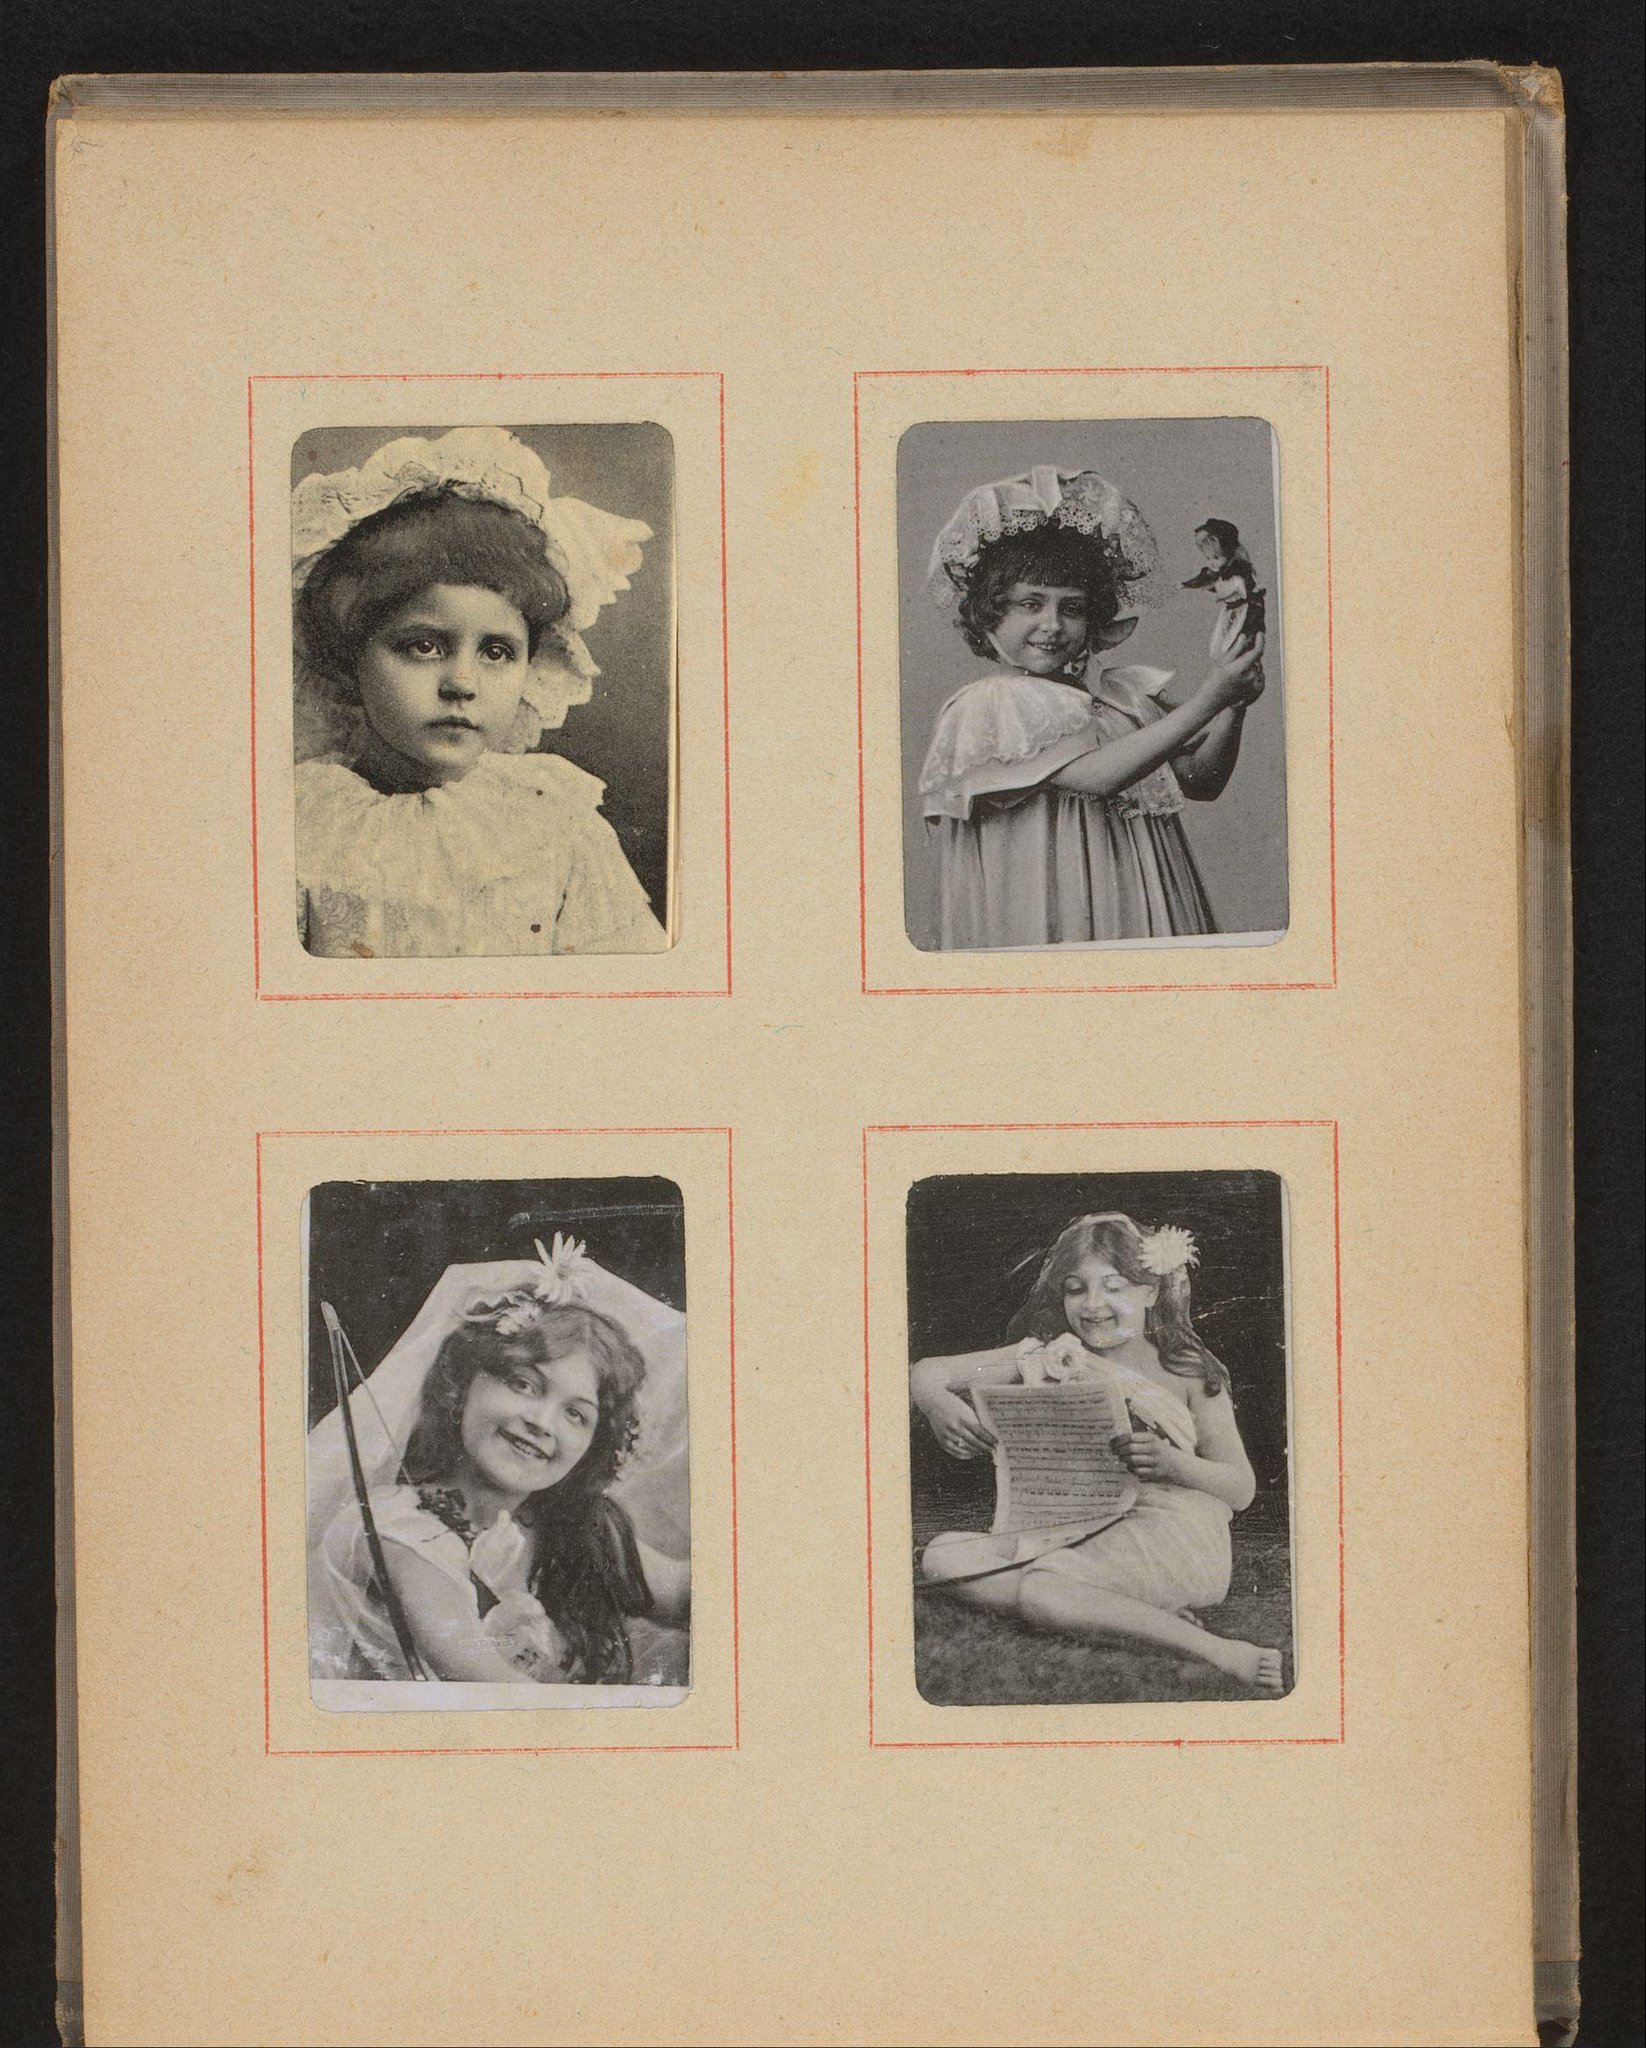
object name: photomechanical print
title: Kinderportretten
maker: Anonymous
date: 1880-1920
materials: paper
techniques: photograph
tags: reading, historical persons, girl (child between toddler and youth), (playing with) dolls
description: Vier portretten van meisjes, waaronder een van een meisje met een pop en een lezend meisje. Deze pagina maakt deel uit van een album.